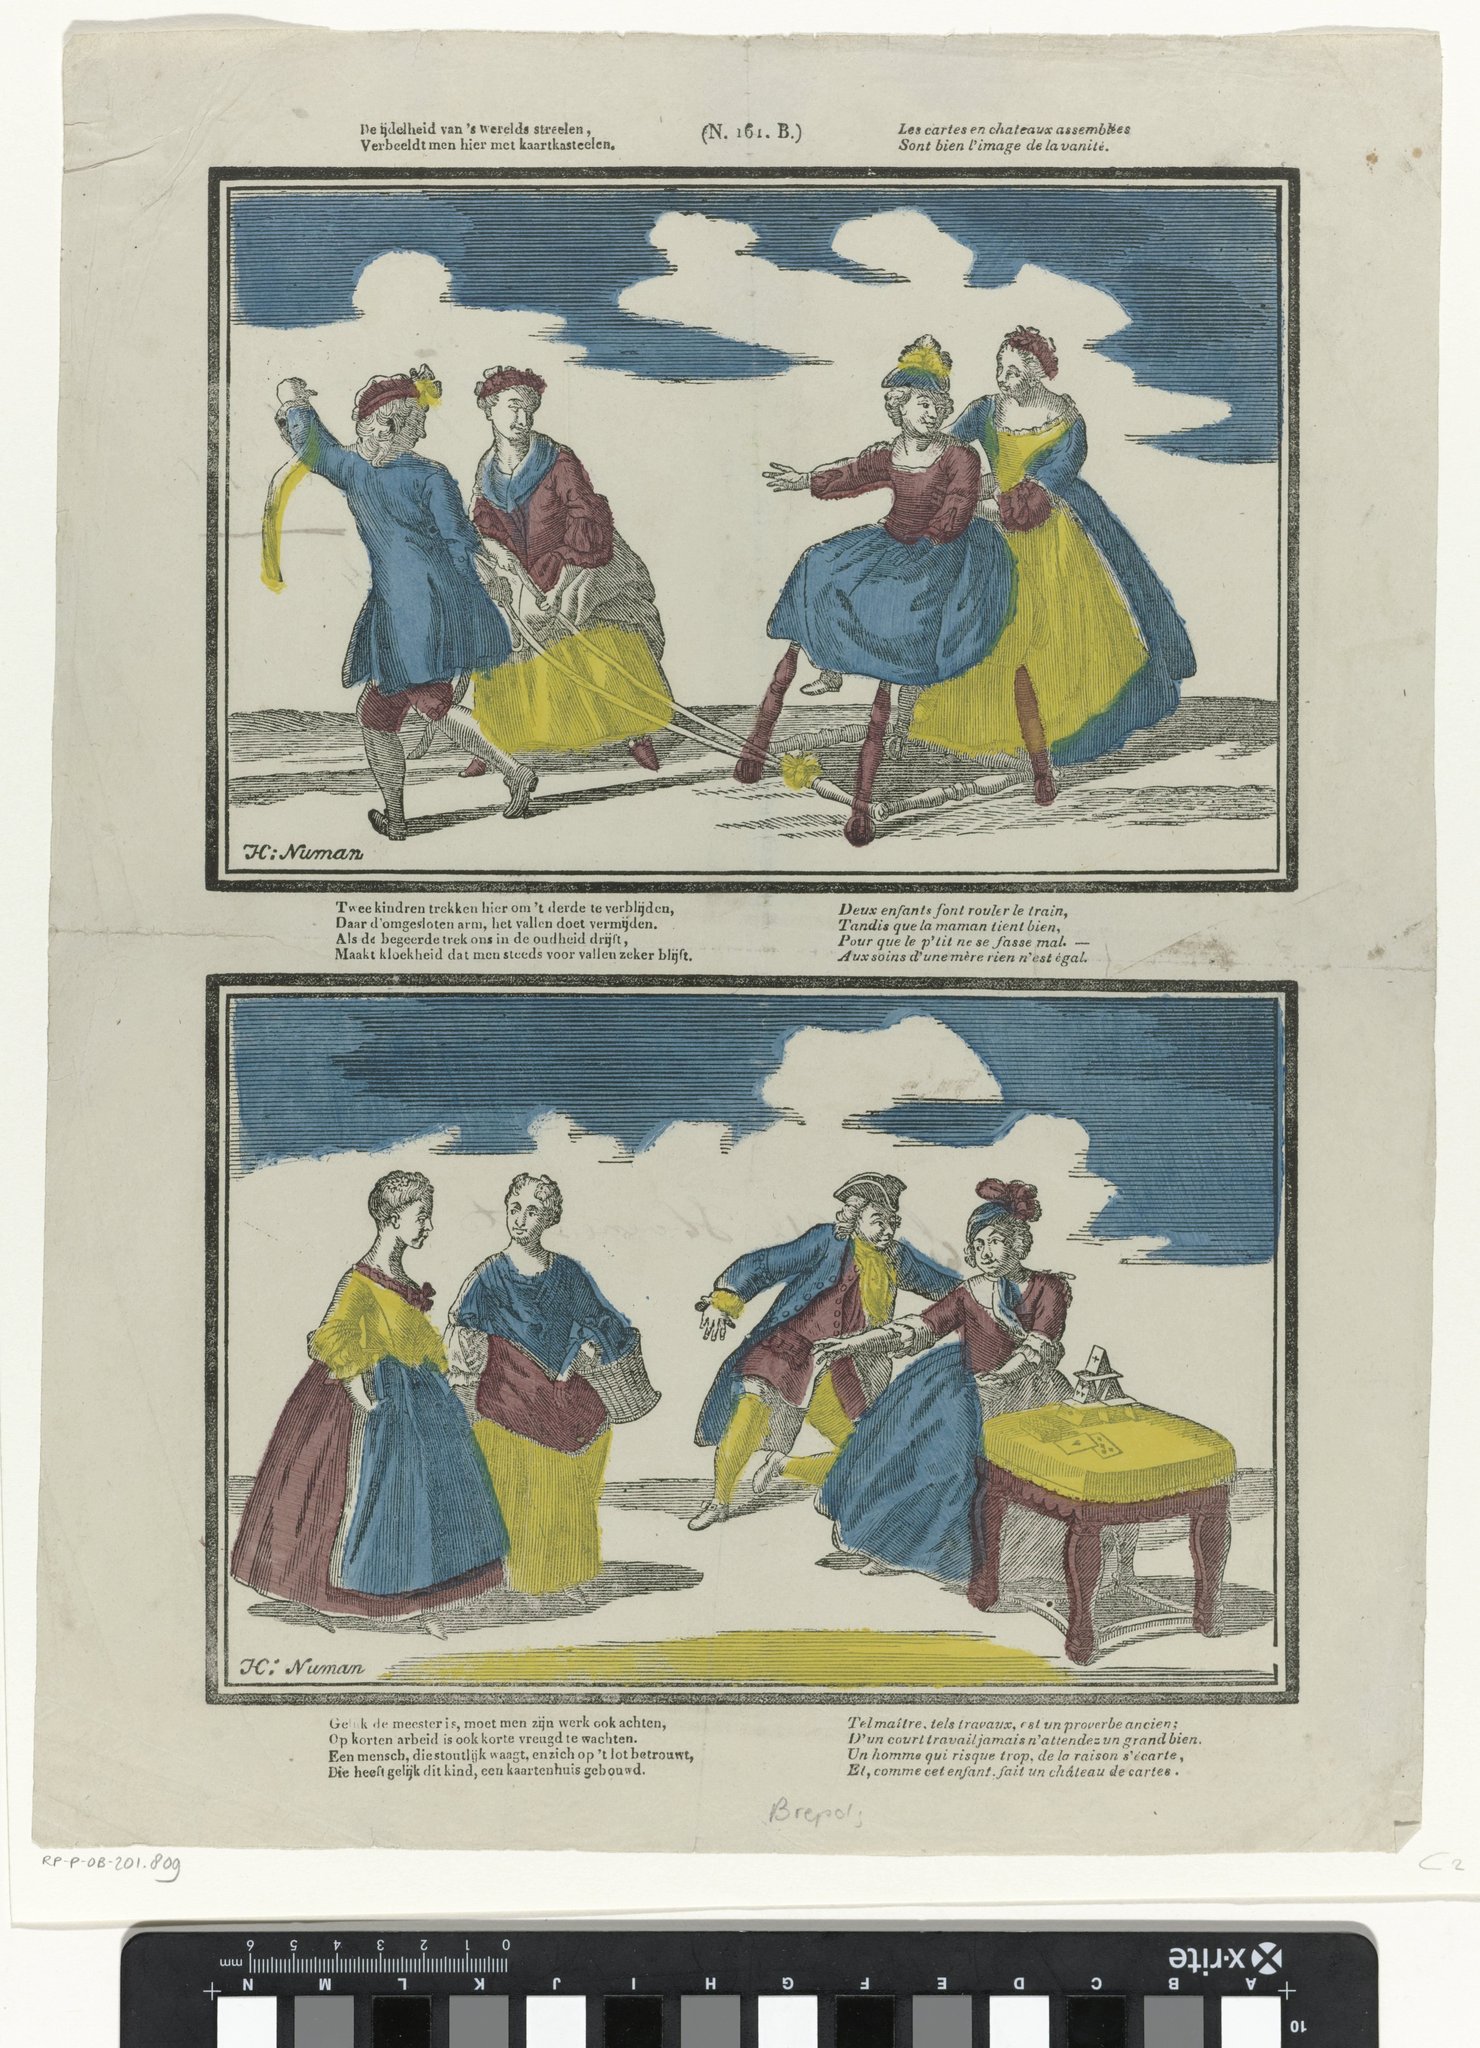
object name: print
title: De ijdelheid van 's werelds streelen, / Verbeeldt men hier met kaartkasteelen / Les cartes en chateaux assemblées / Sont bien l´image de la vanité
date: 1800-1833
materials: paper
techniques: colour, letterpress printing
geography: turnhout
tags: children's games and plays, playing-cards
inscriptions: inscription: ‘Geake: Hoenevet / 1854 / Golsche Hoenevet / 1854 / Geake W. Hoenevet’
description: Blad met 2 voorstellingen van spelende kinderen. Boven trekken twee kinderen een meid op een kar vooruit. Onder bouwt een meid een kaartenhuis. Onder elke afbeelding een vierregelig vers in het Nederlands en in het Frans. Genummerd midden boven: (N. 161. B.).